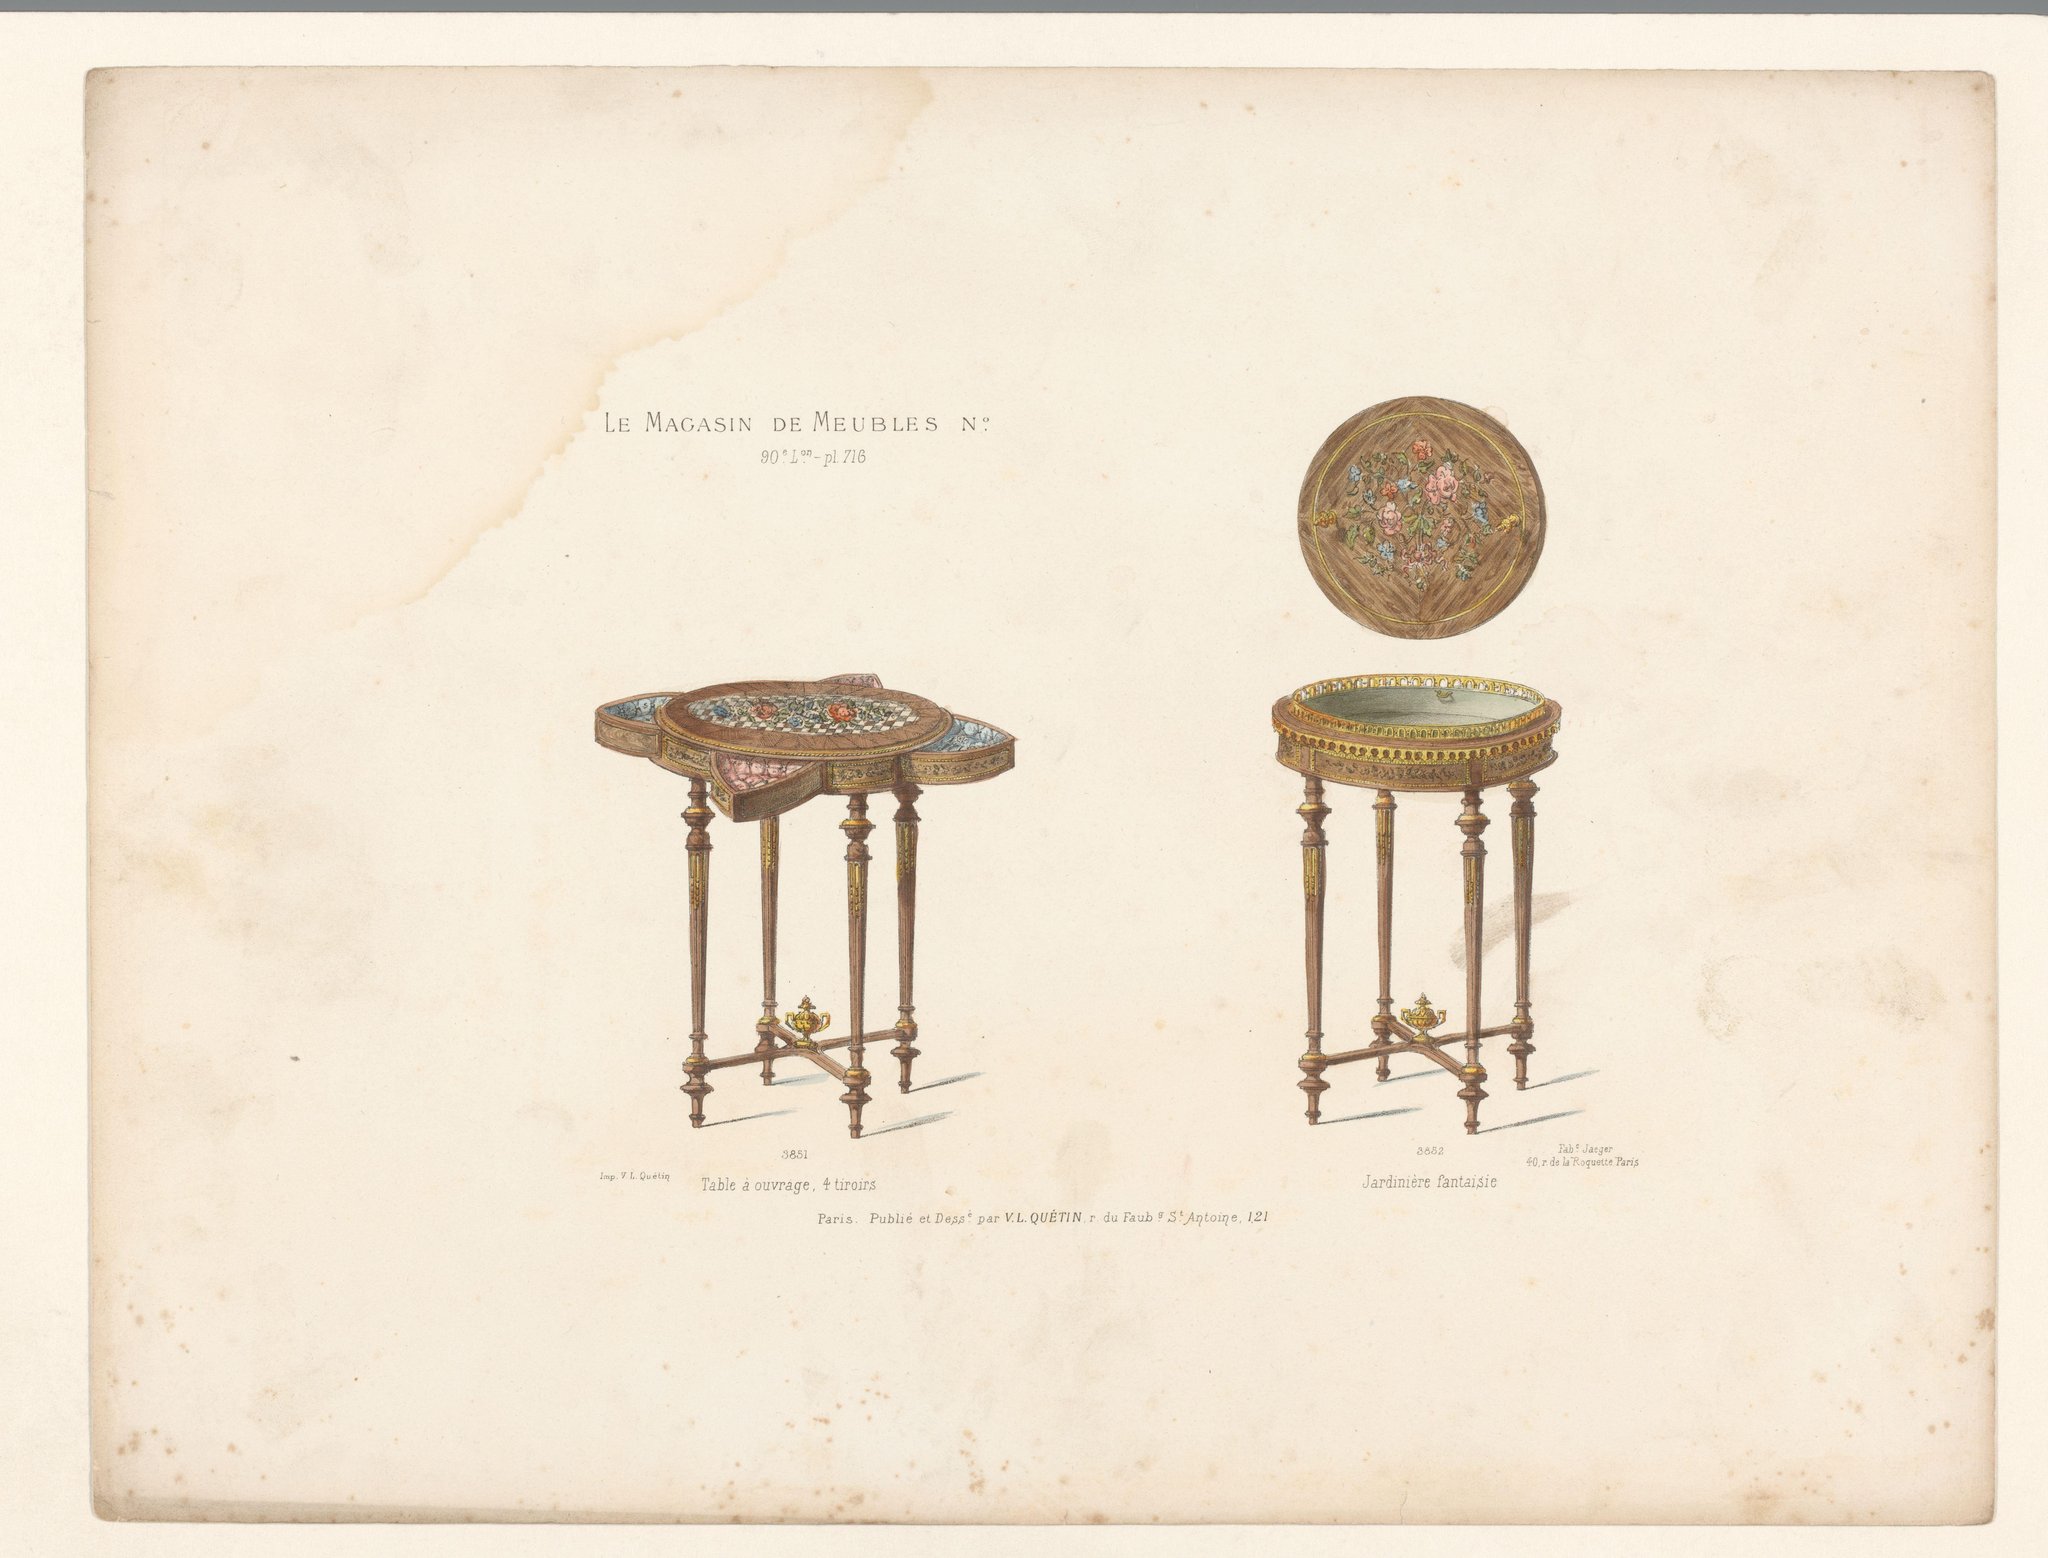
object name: print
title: Le Magasin de Meubles / No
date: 1878-1904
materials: paper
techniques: hand coloring, lithograph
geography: paris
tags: table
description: Een tafel met vier lades en een jardinière met los blad. Prent uit 90e Livraison.